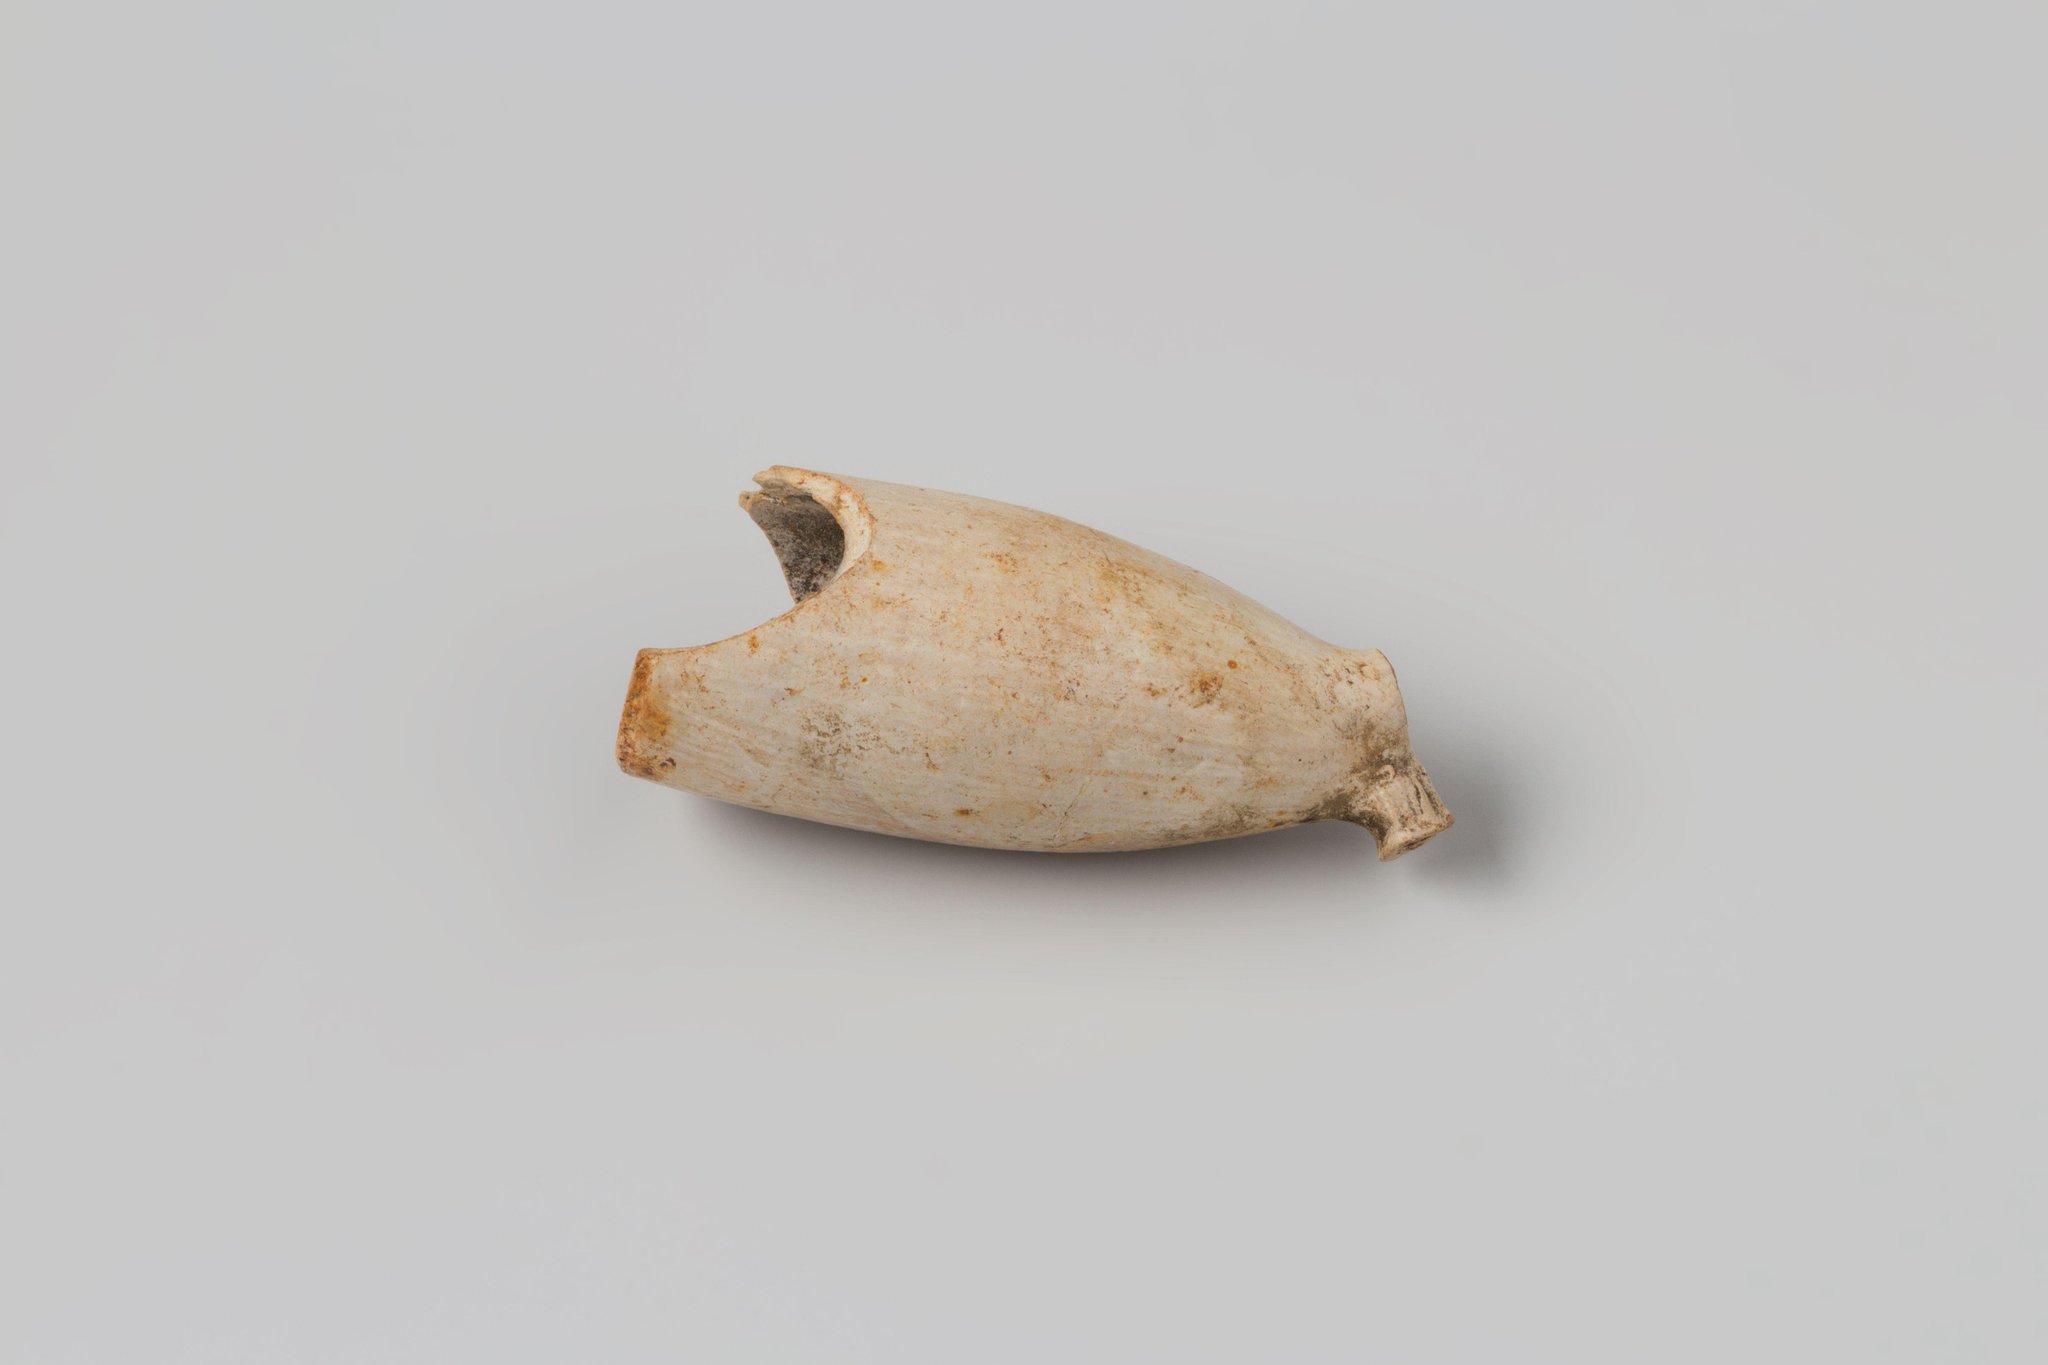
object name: pipe bowl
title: Fragment pijpenkop uit het wrak van de Oost-Indiëvaarder Hollandia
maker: Anonymous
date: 1700-1743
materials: clay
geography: netherlands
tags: verenigde oostindische compagnie, hollandia (schip), annet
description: Pipe, bowl, heelmark: crowned 47; fragment, 2hsm1,3 2hsm3.